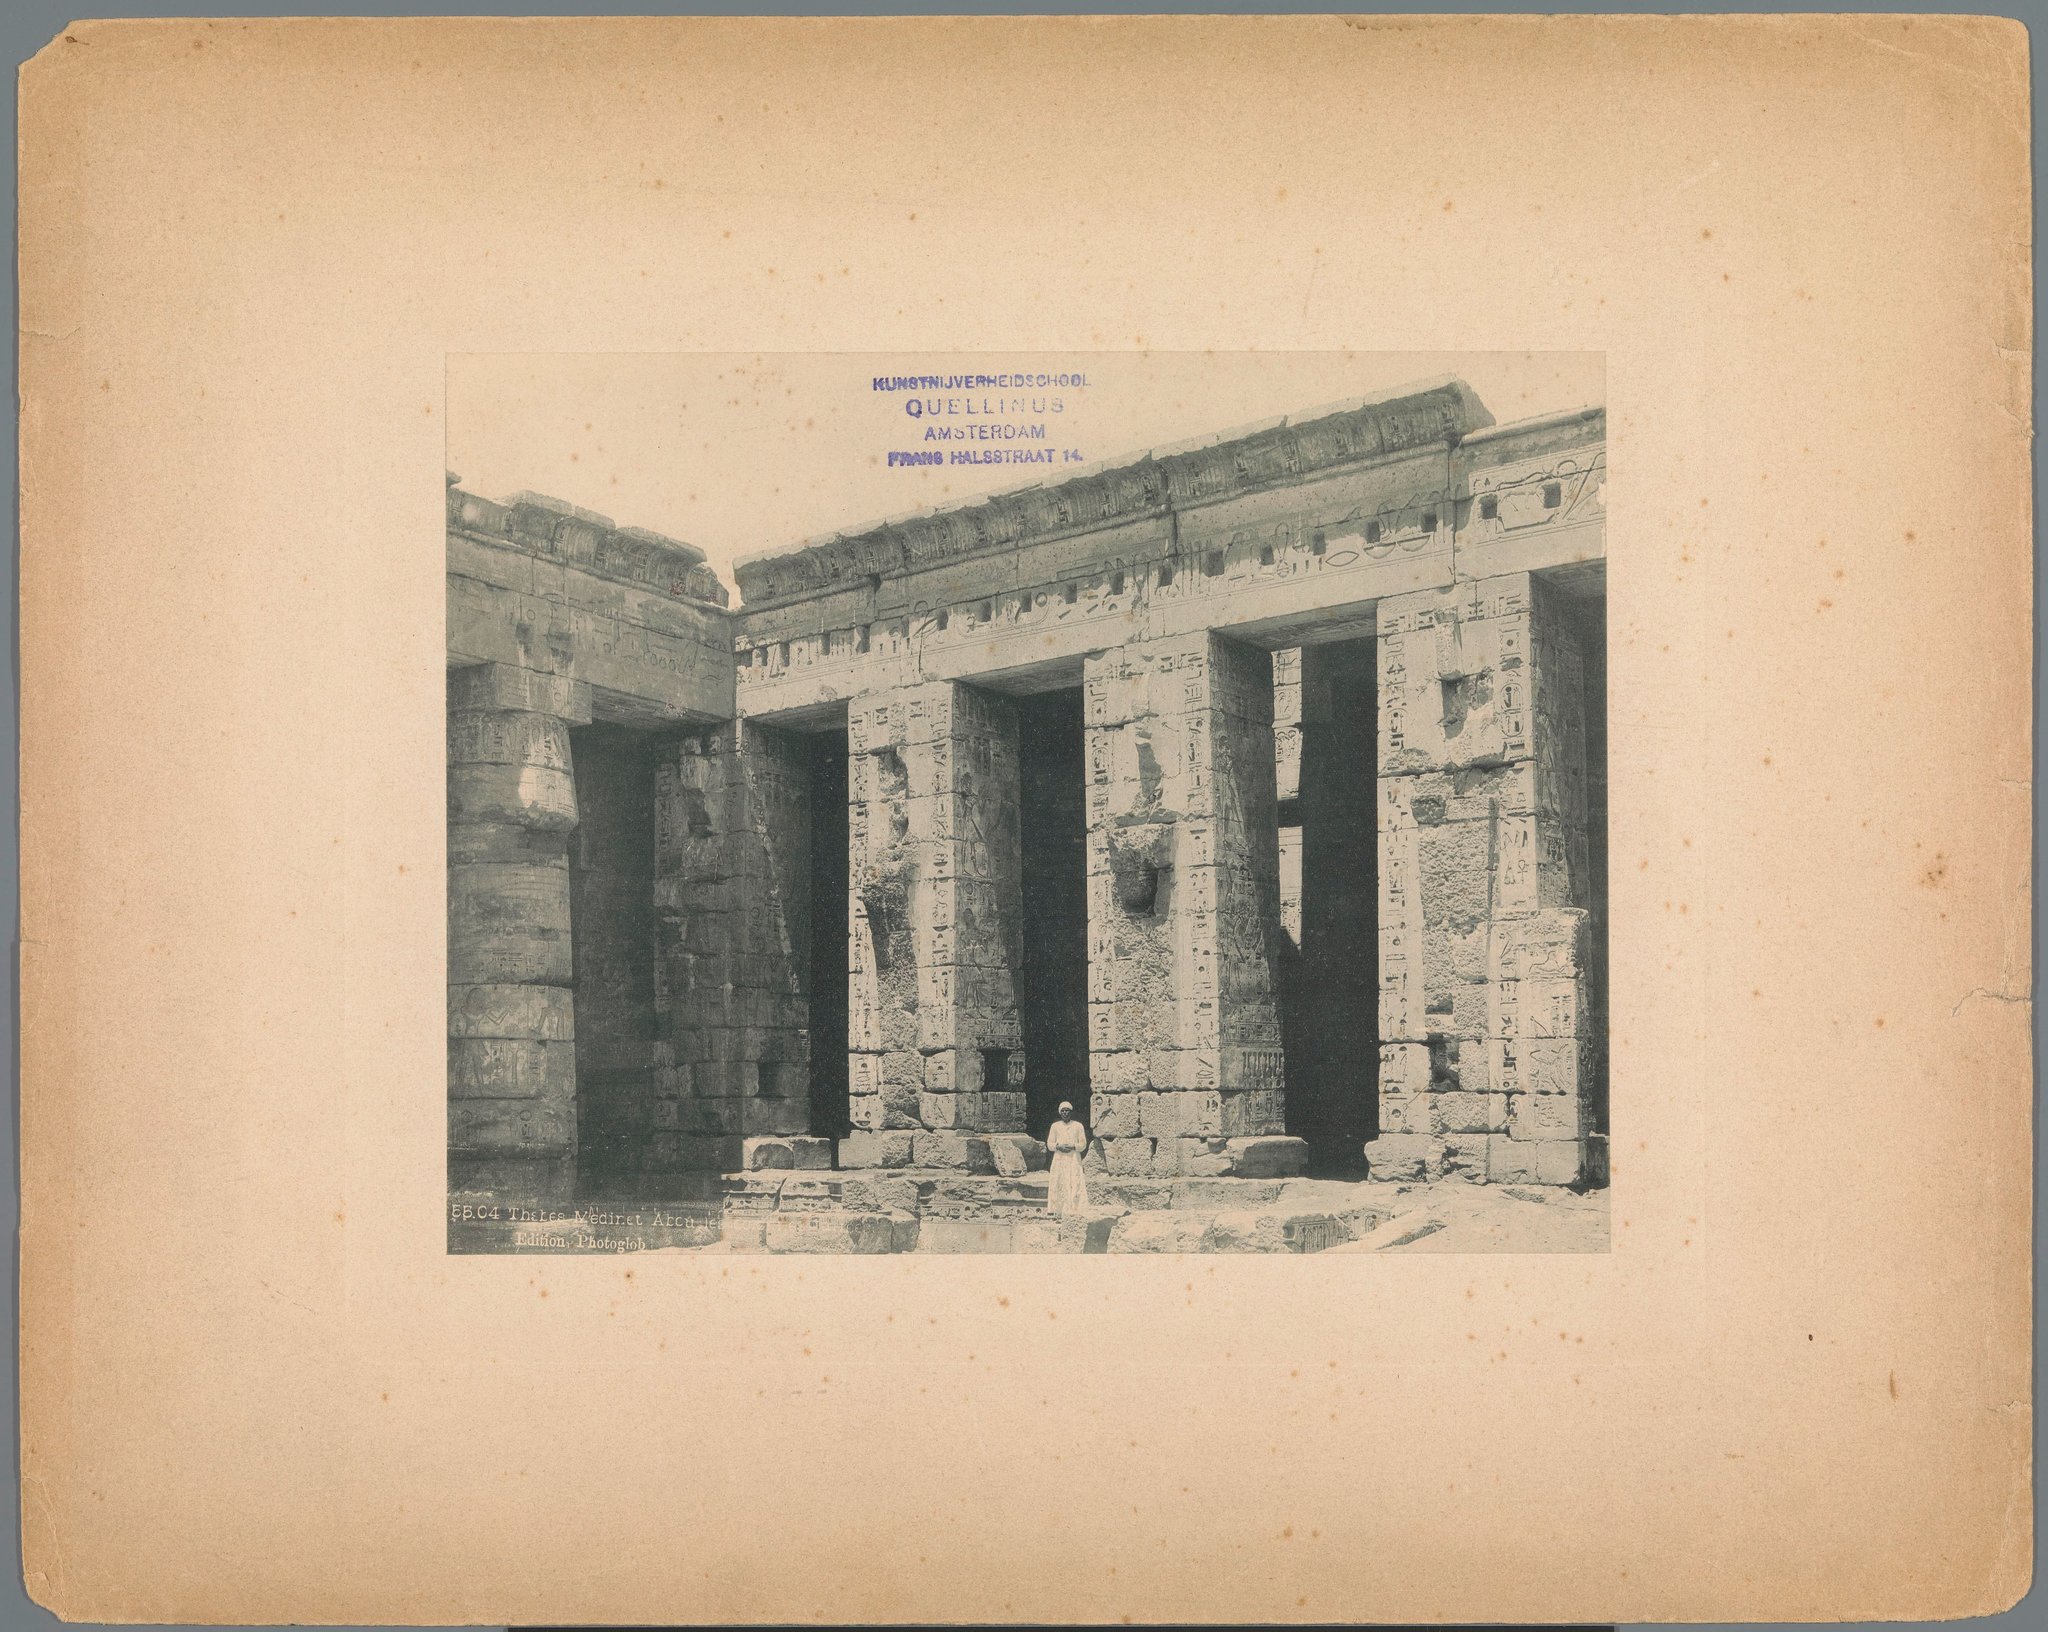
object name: photograph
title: Gevel van de tempel van Ramses III te Medinet Habou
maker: Anonymous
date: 1875-1900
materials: cardboard, ink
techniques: photograph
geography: medinet habu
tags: temple, shrine ~ non-christian religions, façade (of house or building), sculpture (+ relief ~ sculpture)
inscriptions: number: ‘5504’, collector's mark: ‘INSTITUUT VOOR KUNST- NIJVERHEIDSONDERWIJS GABRIËL METSUSTRAAT No. 16. AMSTERDAM’, collector's mark: ‘KUNSTNIJVERHEIDSCHOOL QUELLINUS AMSTERDAM FRANS HALSSTRAAT 14.’